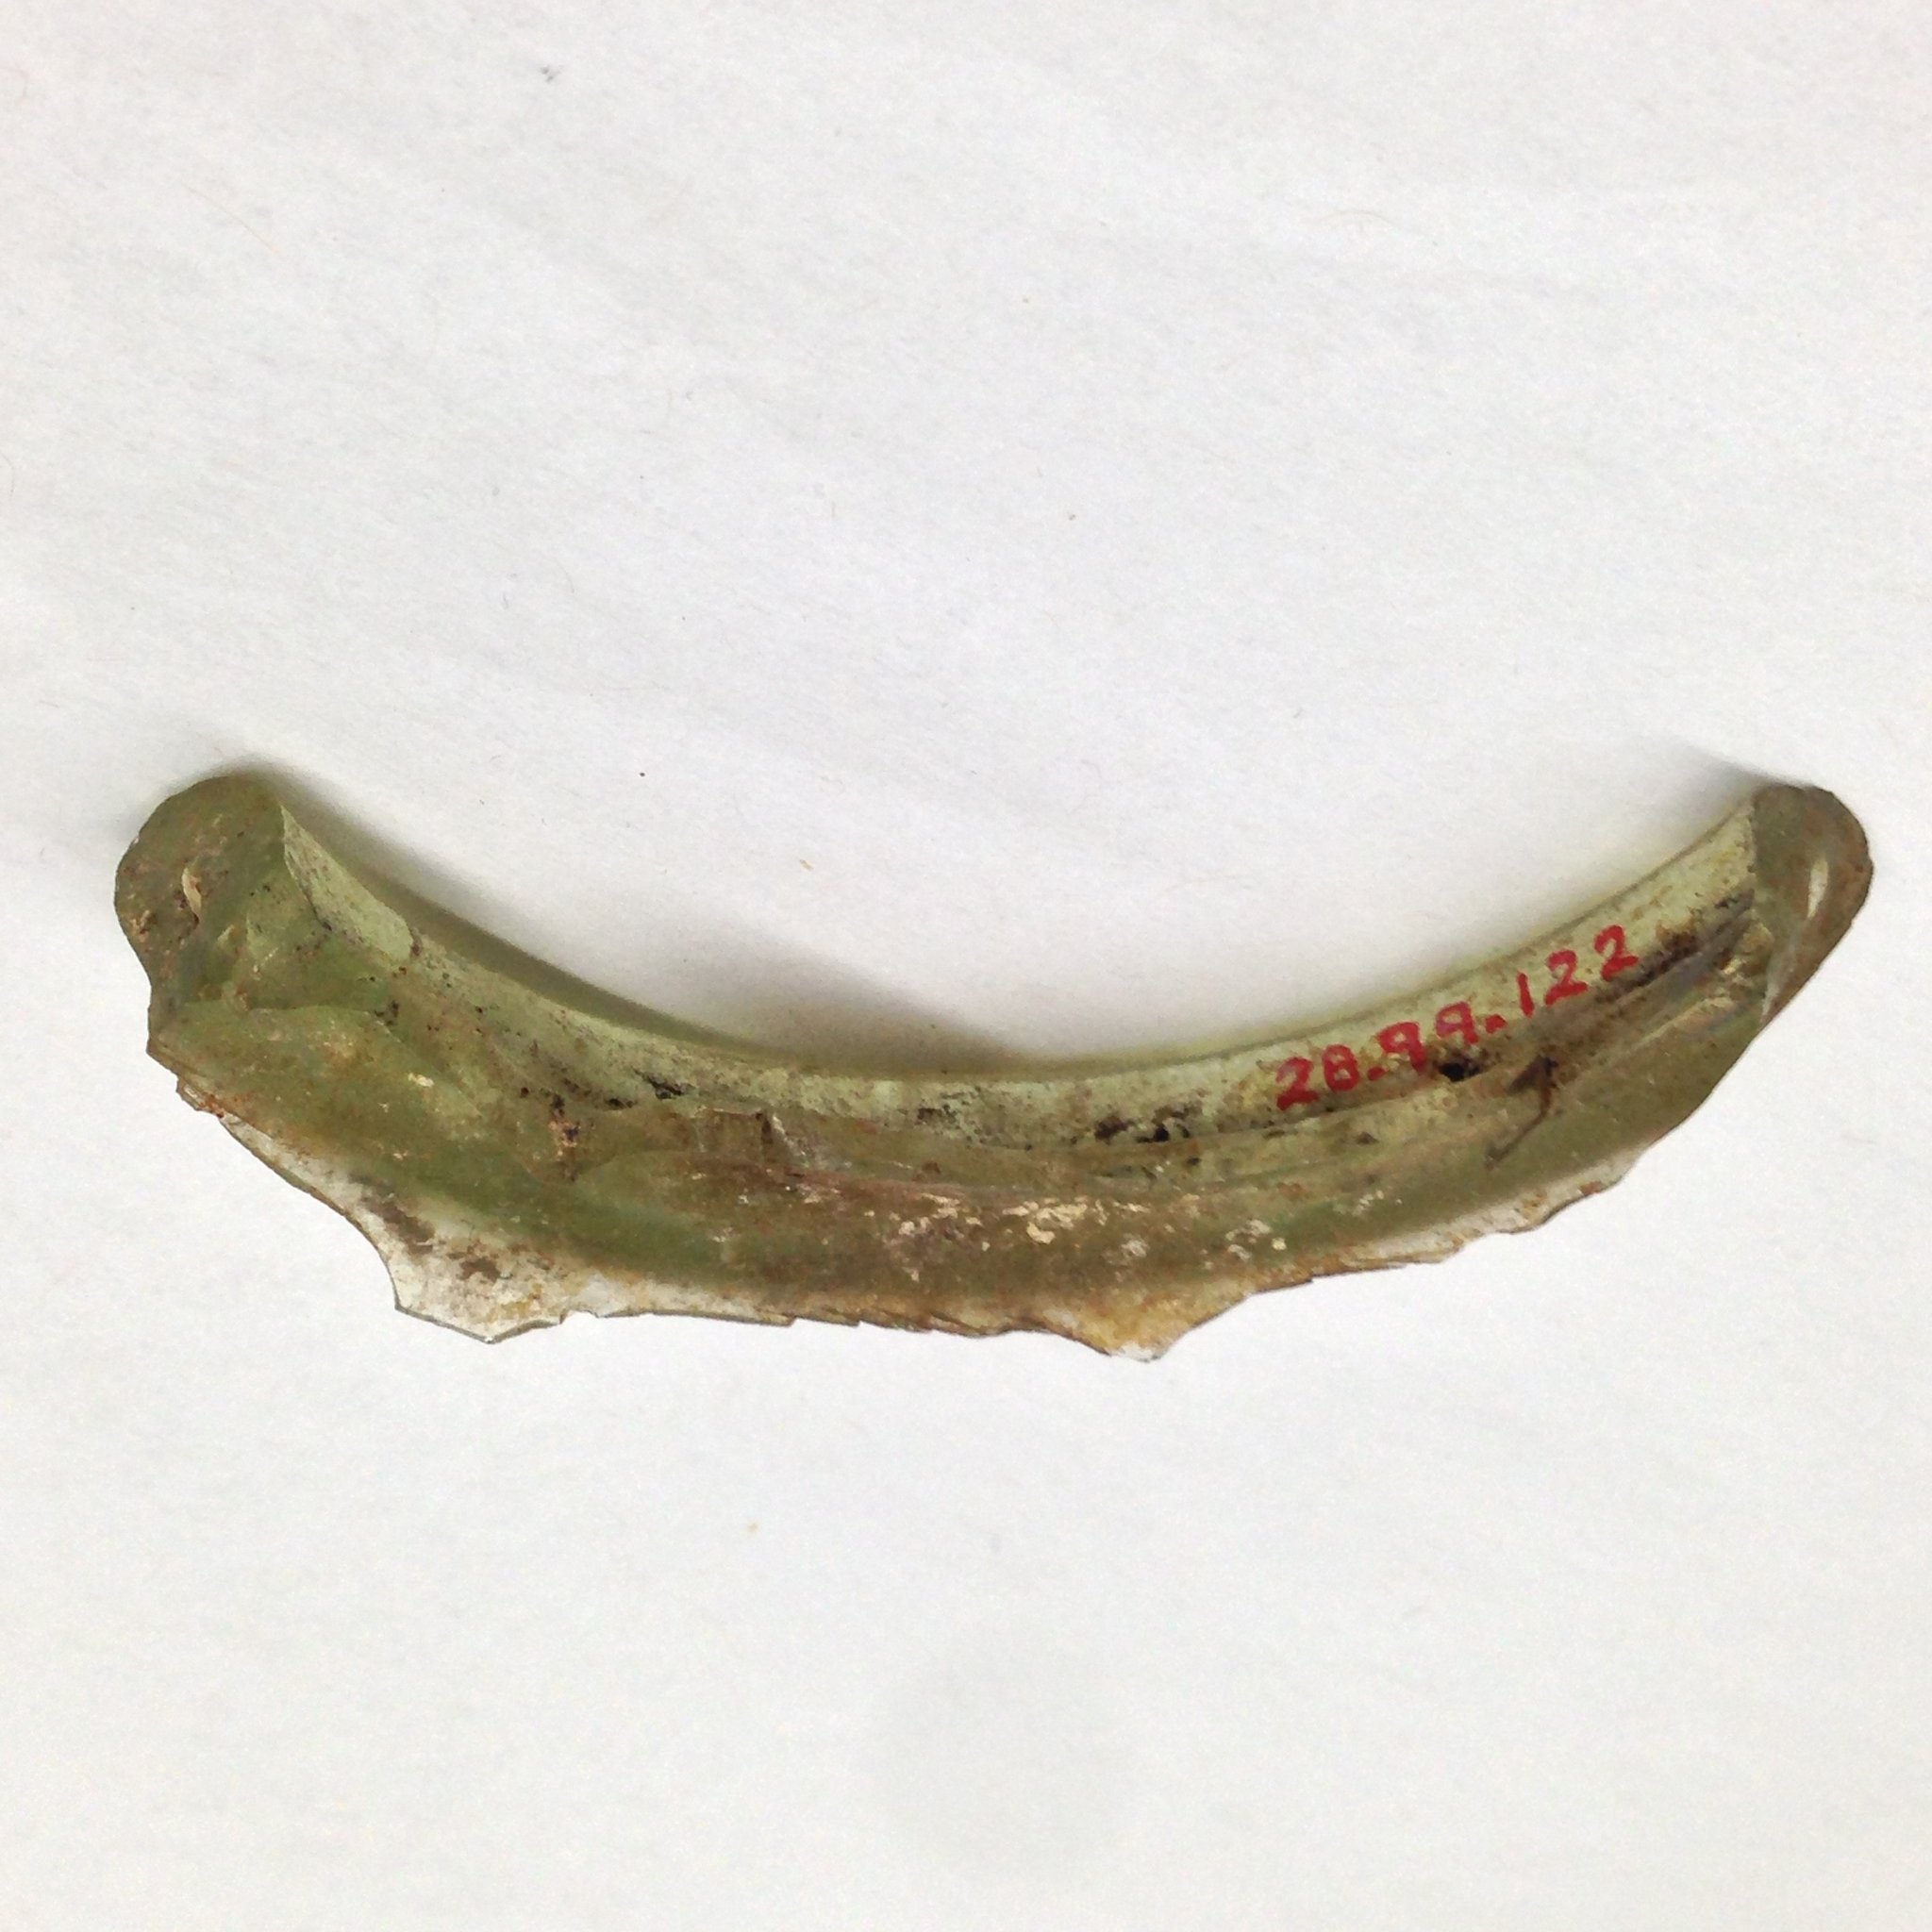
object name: fragment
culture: european or middle eastern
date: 1150-1250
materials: ceramic, glass